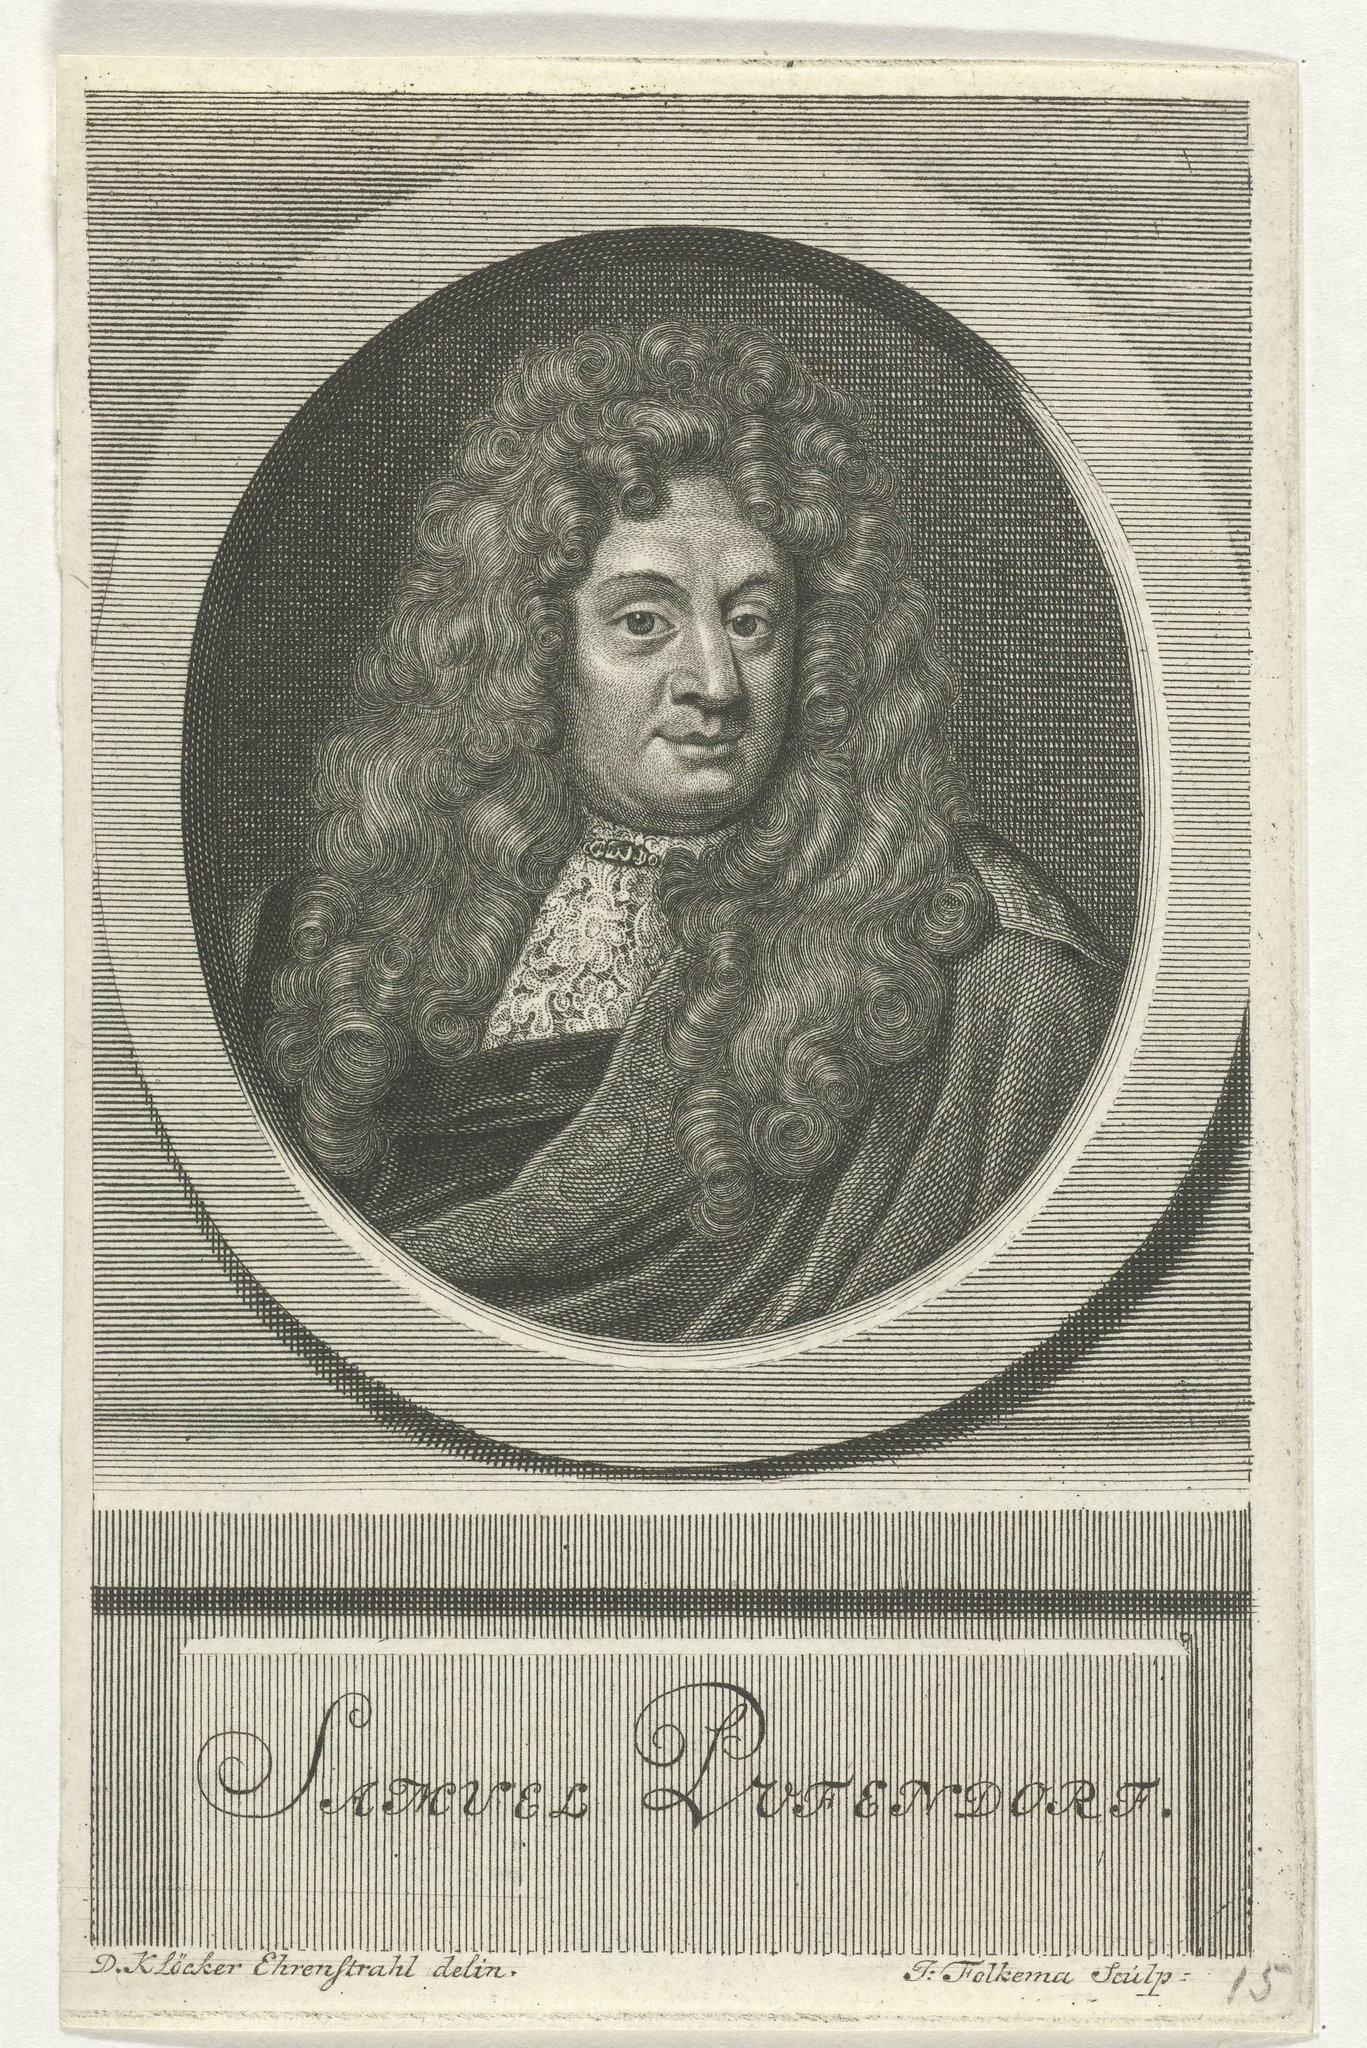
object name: print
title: Portret van Samuel von Pufendorf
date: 1732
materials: paper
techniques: engraving, etching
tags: berlin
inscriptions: number: ‘15’, collector's mark: Lugt 240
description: Prent waarschijnlijk uit: Pufendorf, Samuel von. Histoire de suede, avant et depuis la fondation de la monarchie. Amsterdam: Zacharie Chatelain, 1732.